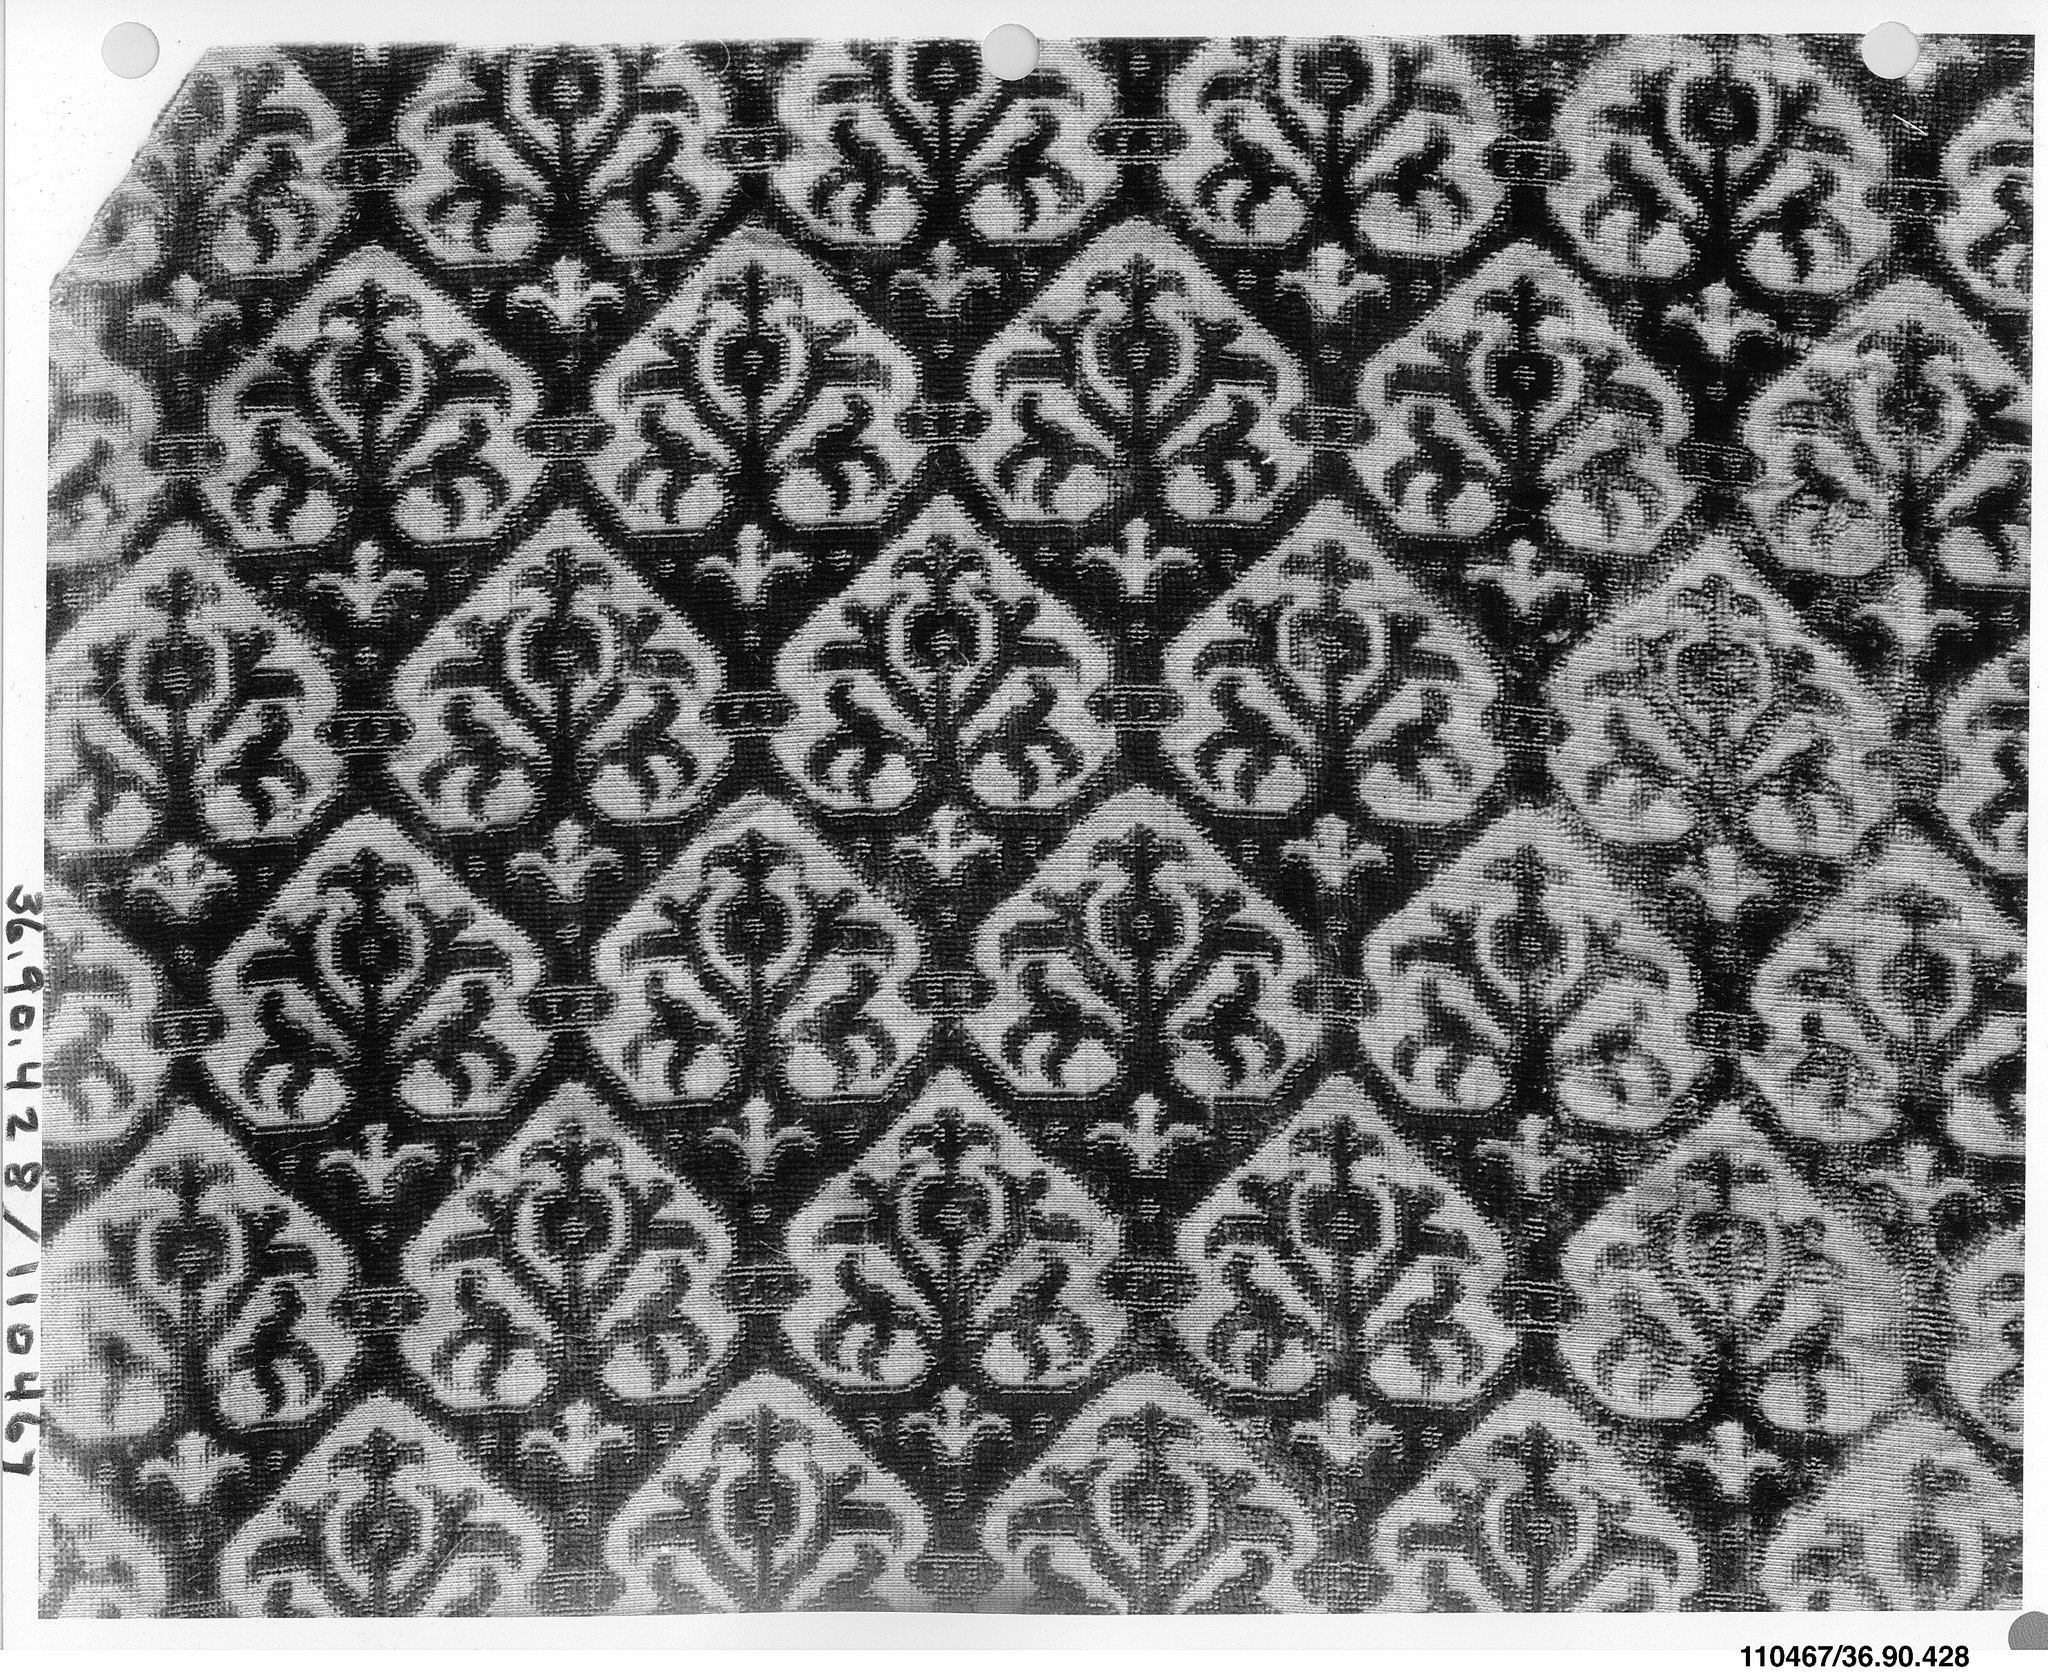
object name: piece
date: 1501-1700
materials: silk